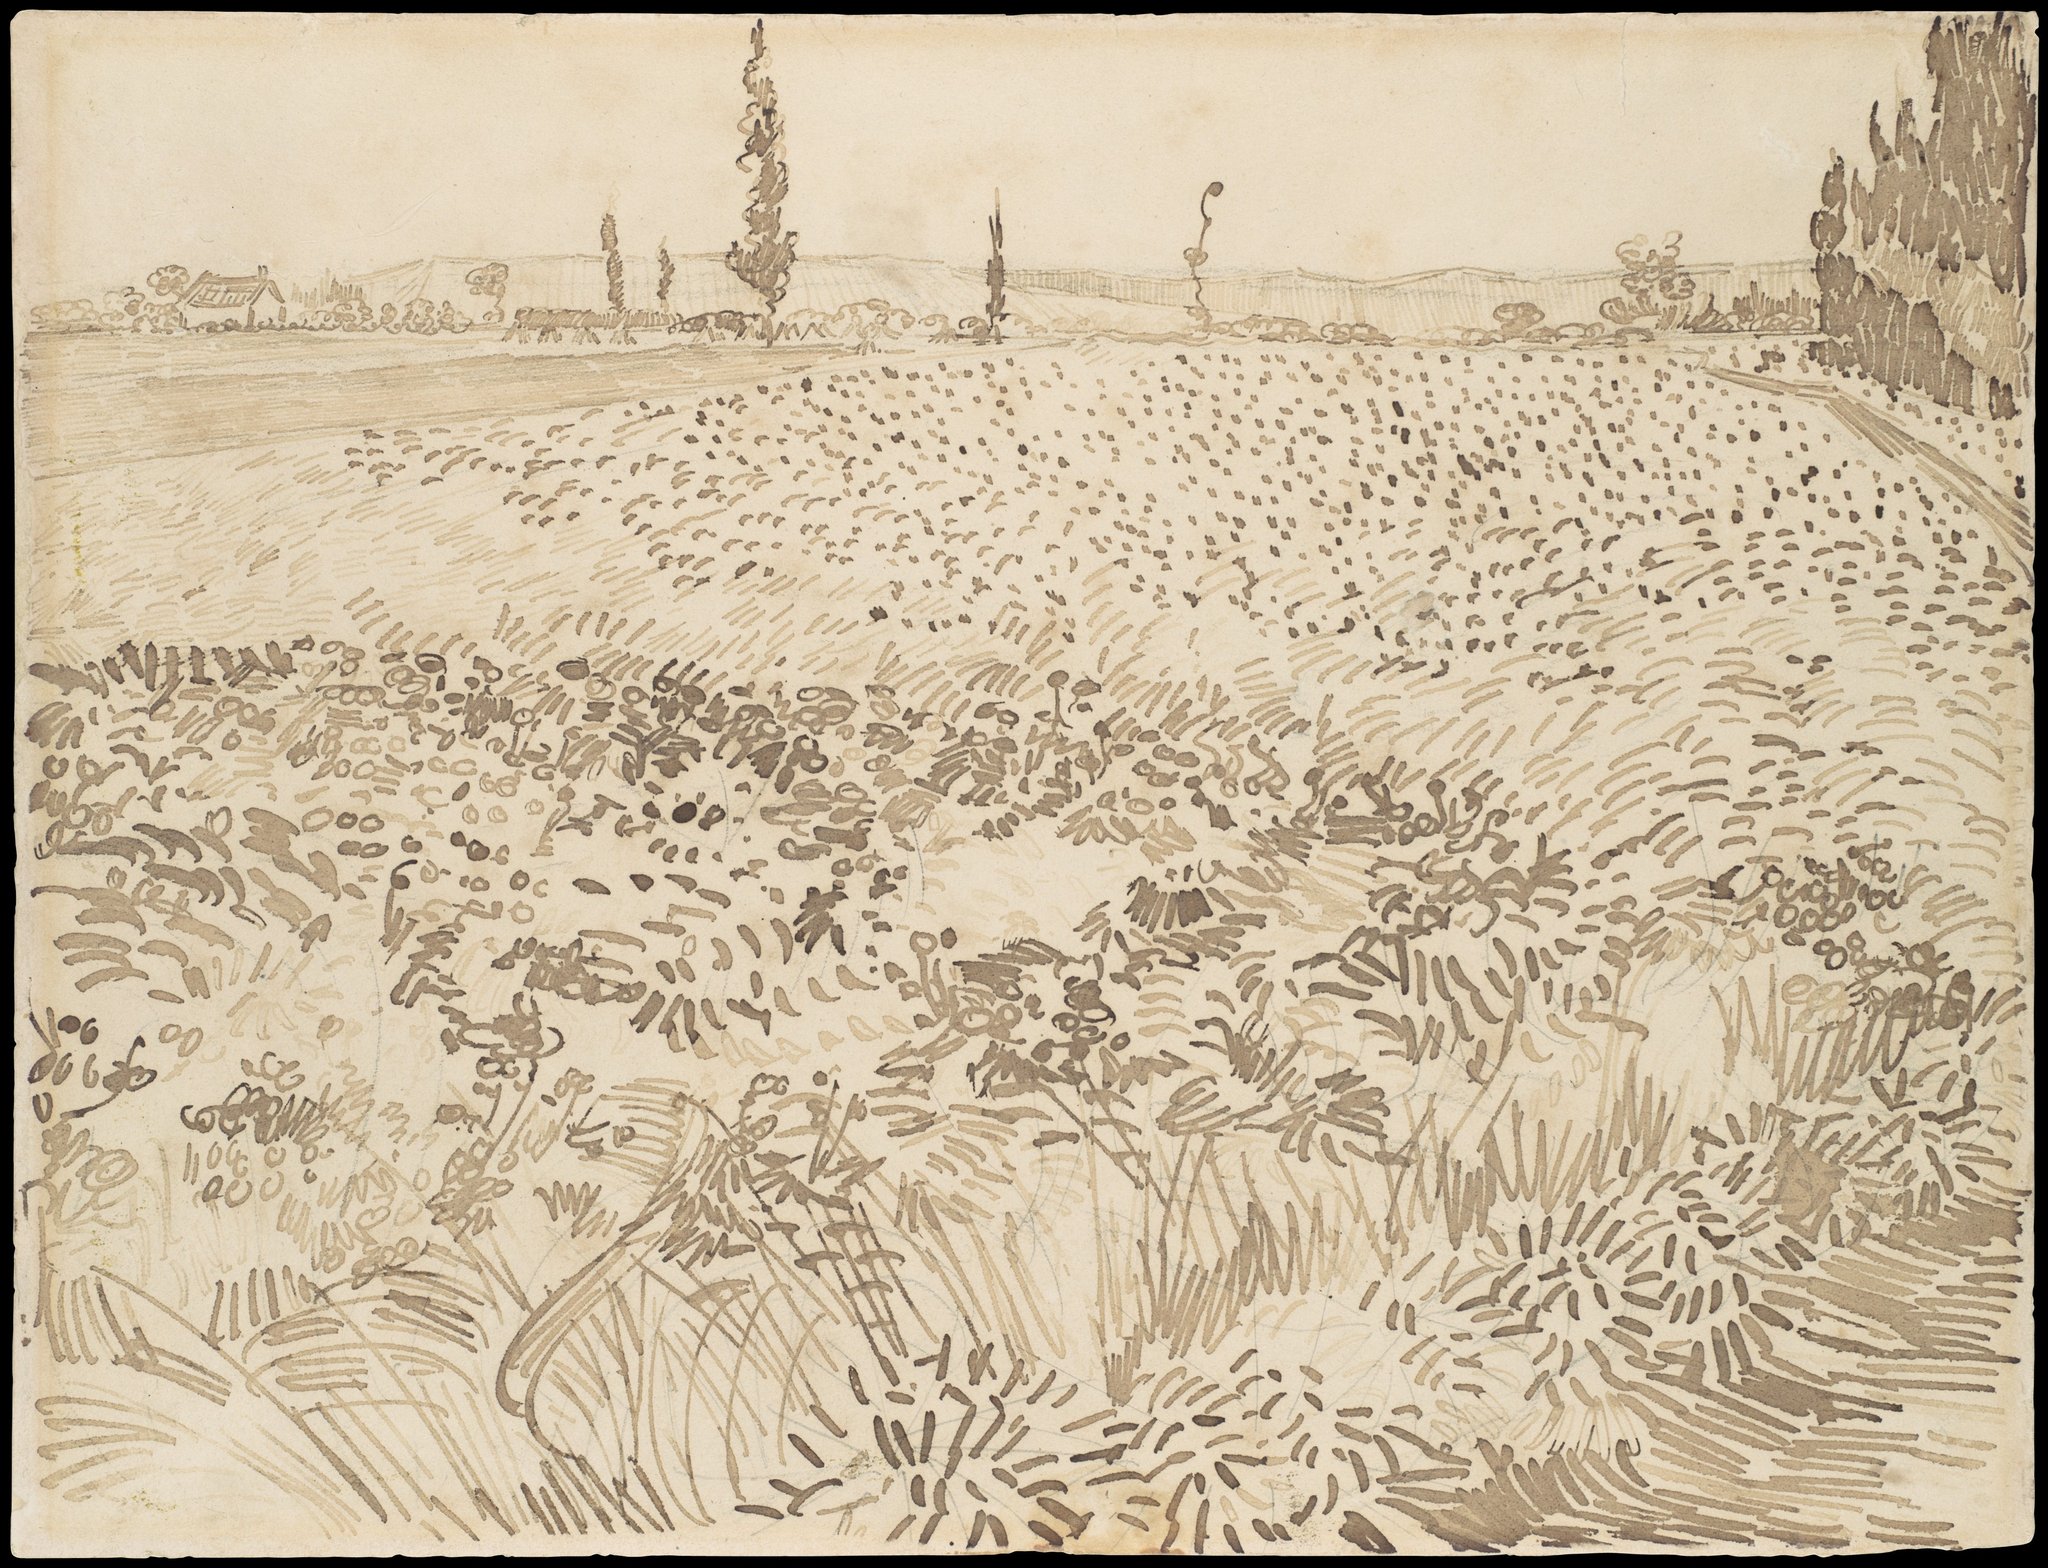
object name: drawing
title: Wheat Field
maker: vincent van gogh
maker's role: artist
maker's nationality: dutch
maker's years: 1853-1890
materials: graphite, ink, paper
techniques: pen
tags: landscapes